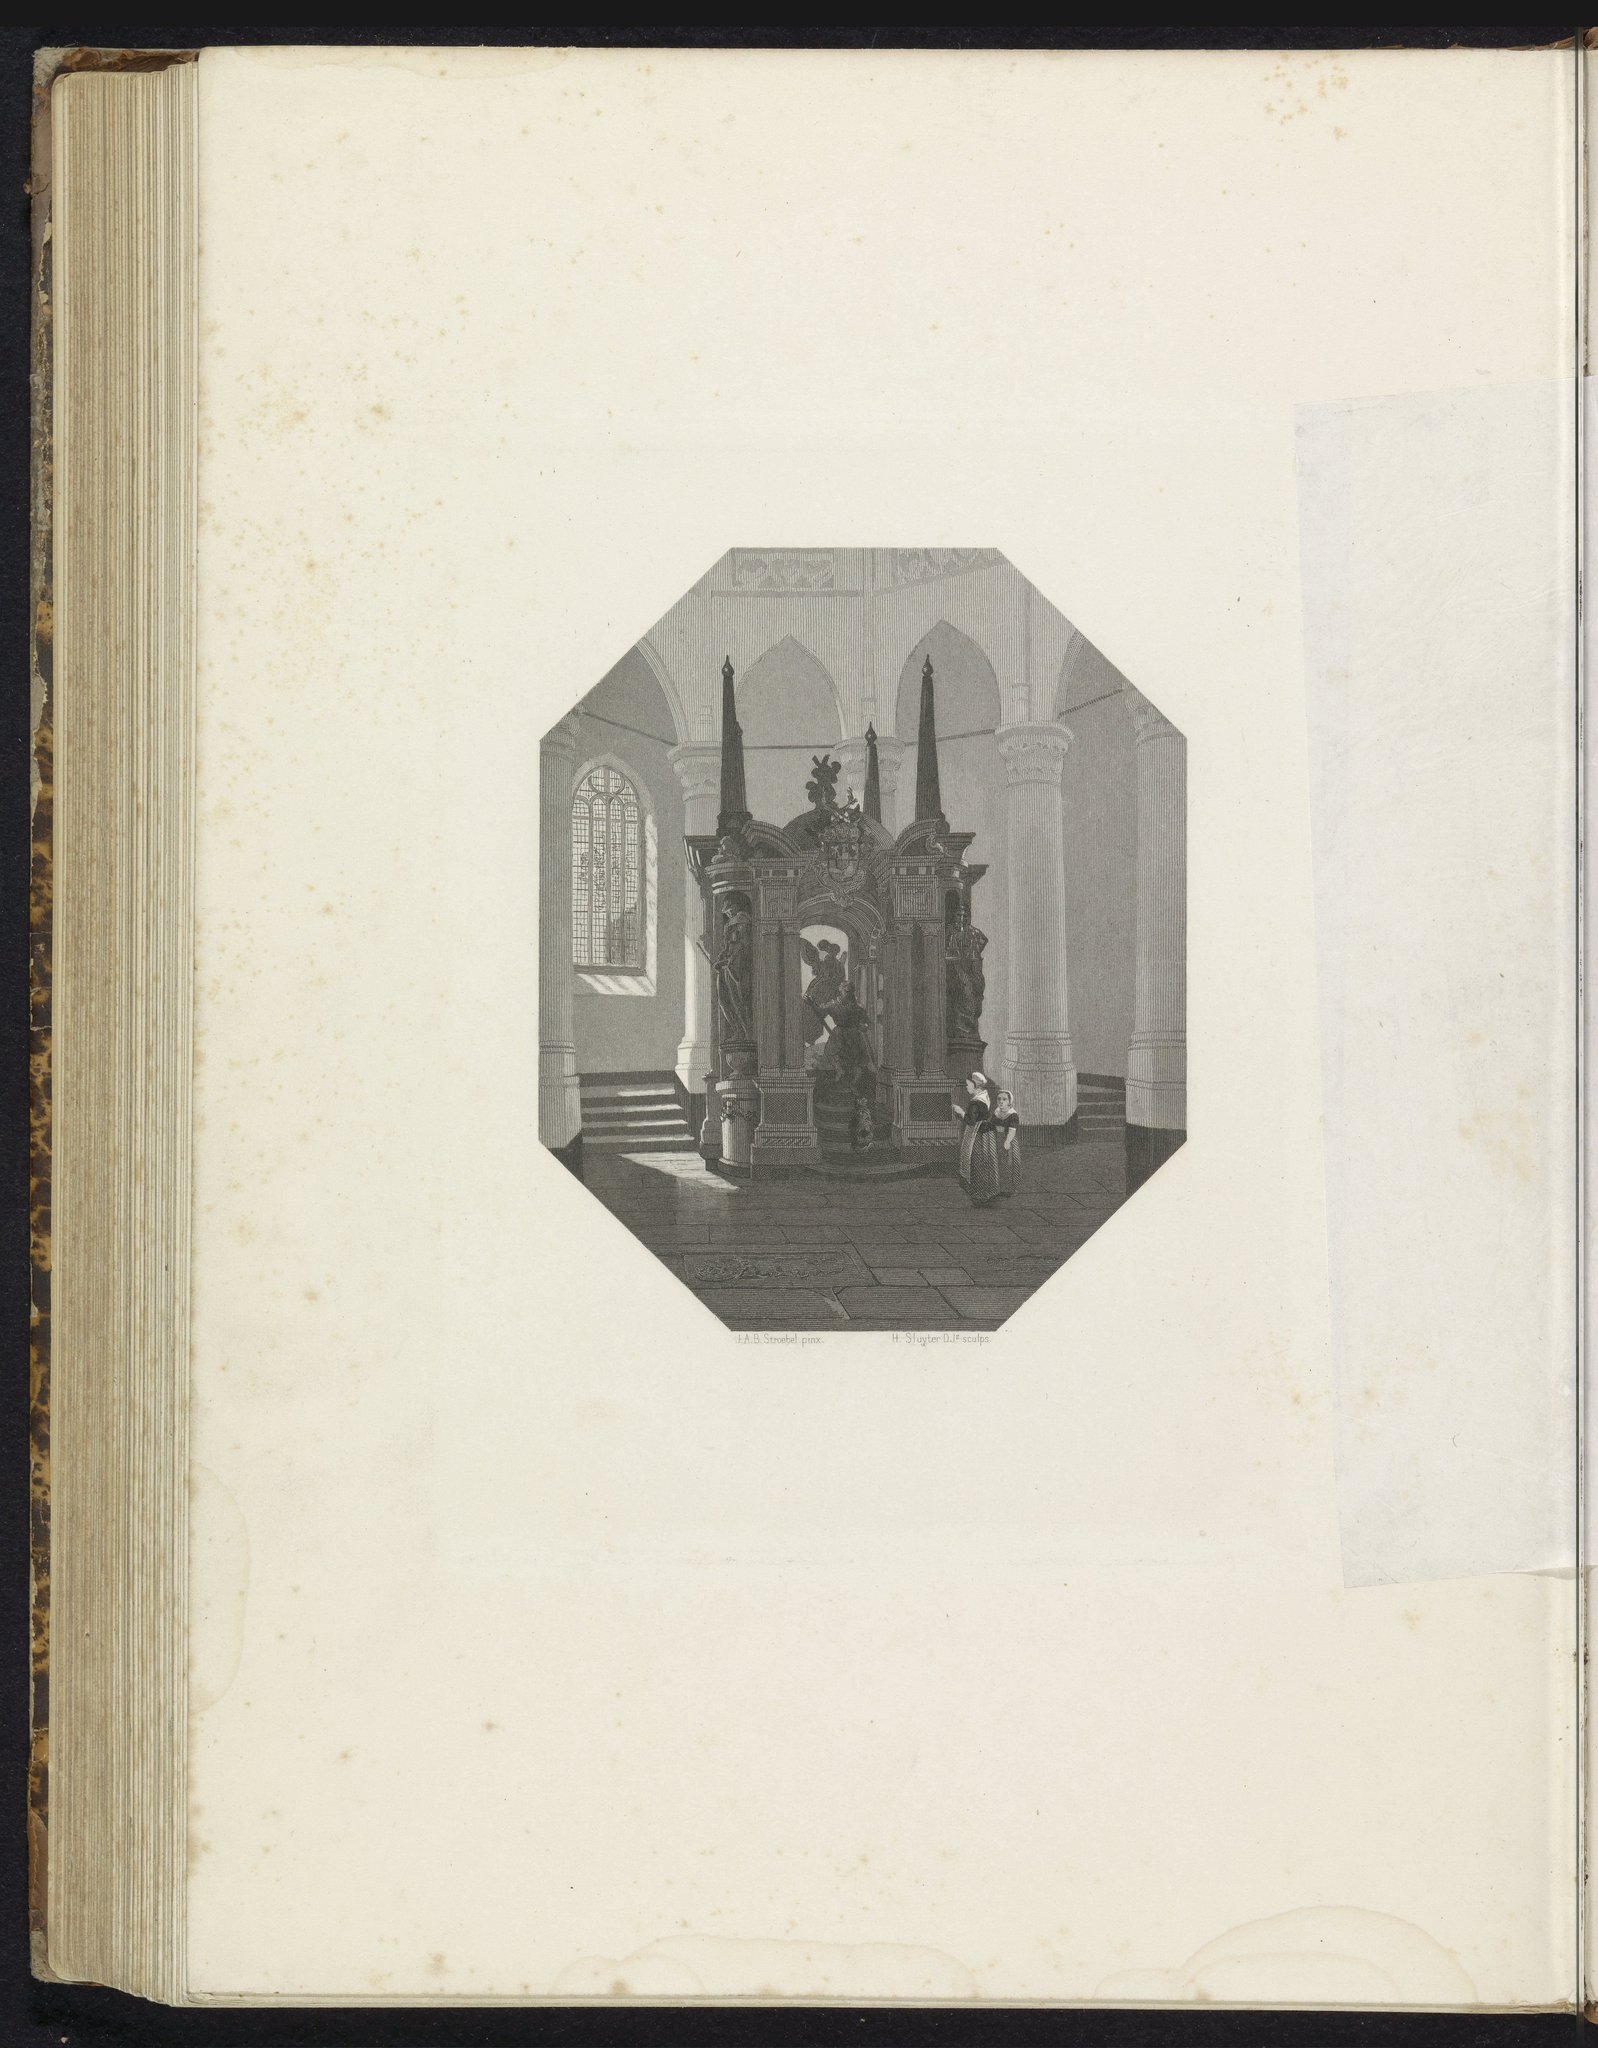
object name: history print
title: Het praalgraf van Prins Willem te Delft, ca. 1625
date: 1865-1870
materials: paper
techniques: engraving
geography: netherlands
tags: delft, william i (prince of orange), piece of sculpture, reproduction of a piece of sculpture, grave-building, monumental tomb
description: Het praalgraf van prins Willem van Oranje in de Nieuwe Kerk te Delft, voltooid in 1623. Onderdeel van de groep staalgravures naar de schilderijen van de Historische Galerij der Maatschappij Arti et Amicitiae.